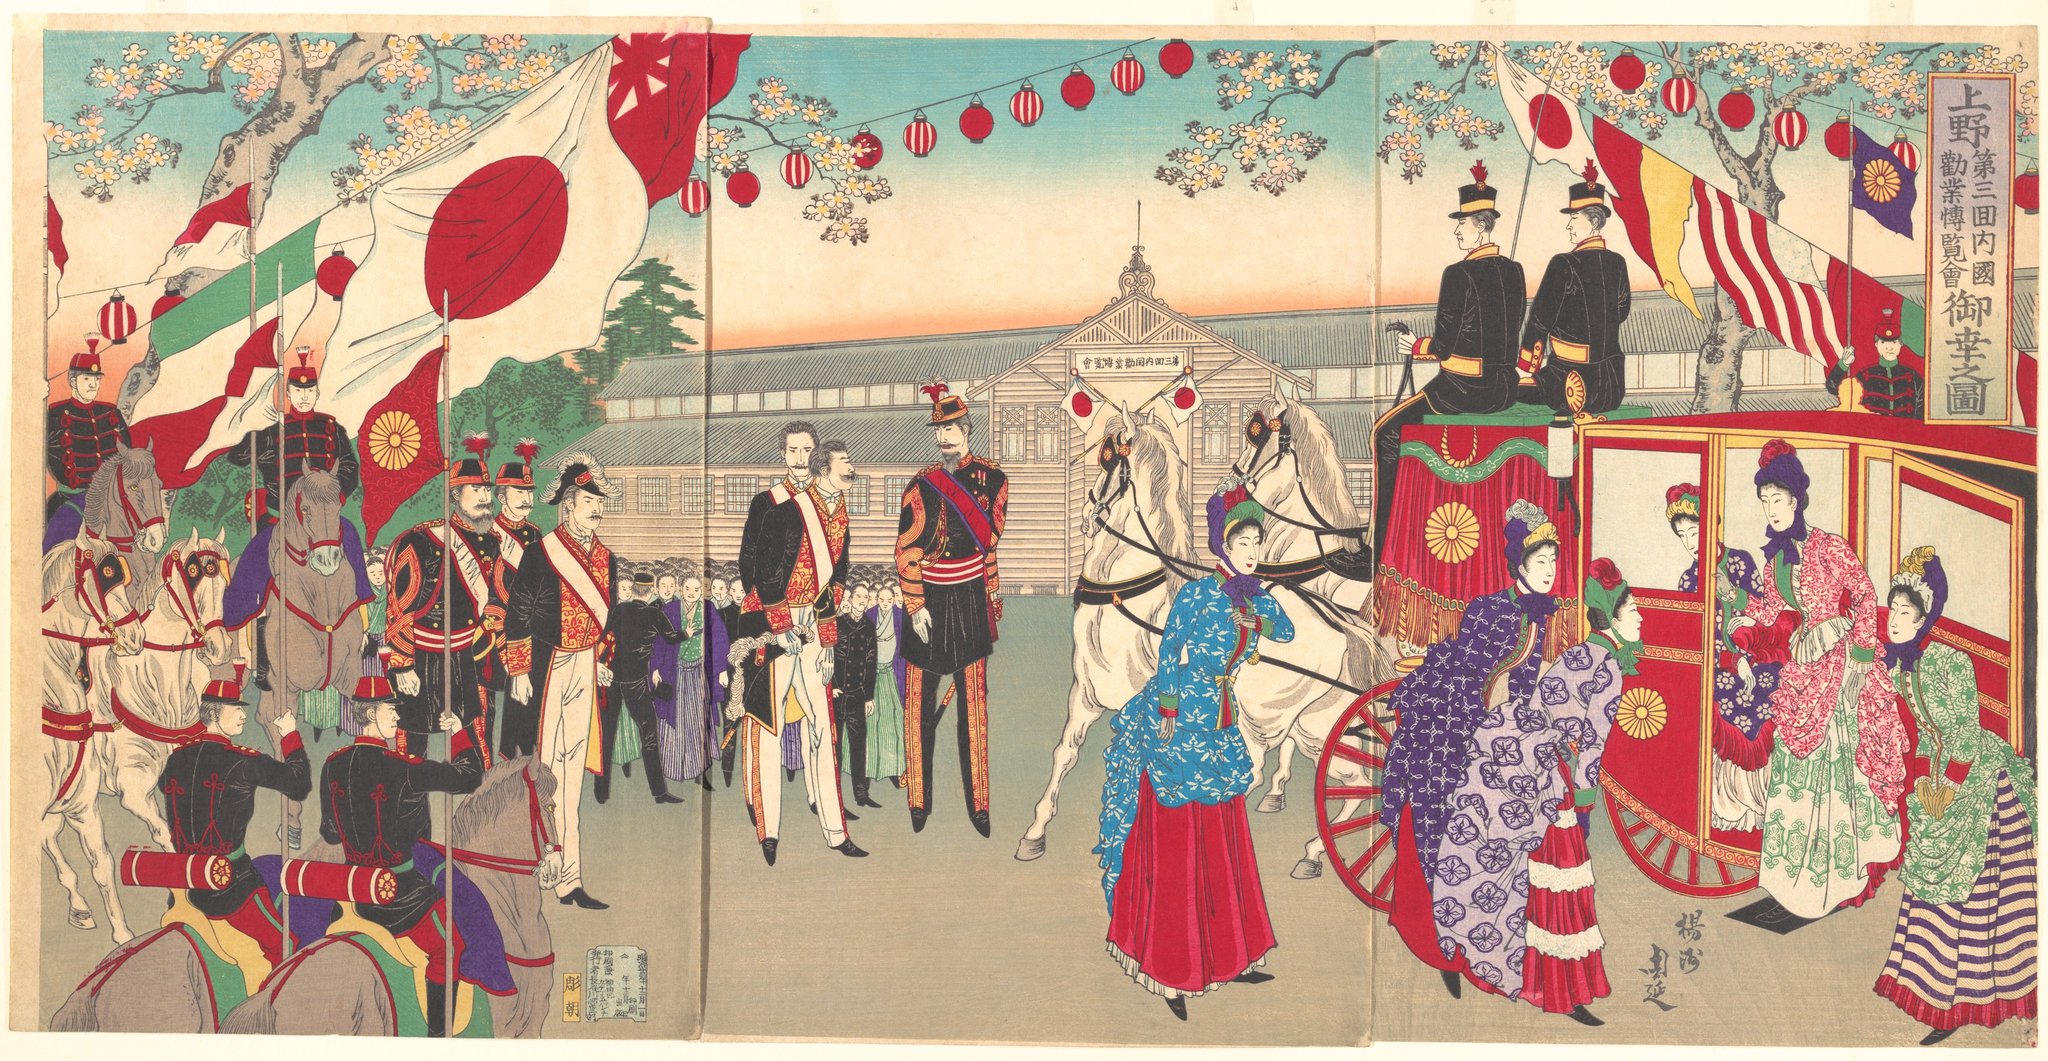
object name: print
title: Visit of the Empress to the Third National Industrial Promotional Exhibition at Ueno Park (Ueno dai sankai naikoku kangyō hakuran kai gyokō no zu)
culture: japanese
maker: yōshū (hashimoto) chikanobu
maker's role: artist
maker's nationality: japanese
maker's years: 1838-1912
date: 1889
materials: ink, paper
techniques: woodblock print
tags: horses,crowd,flags,carriages